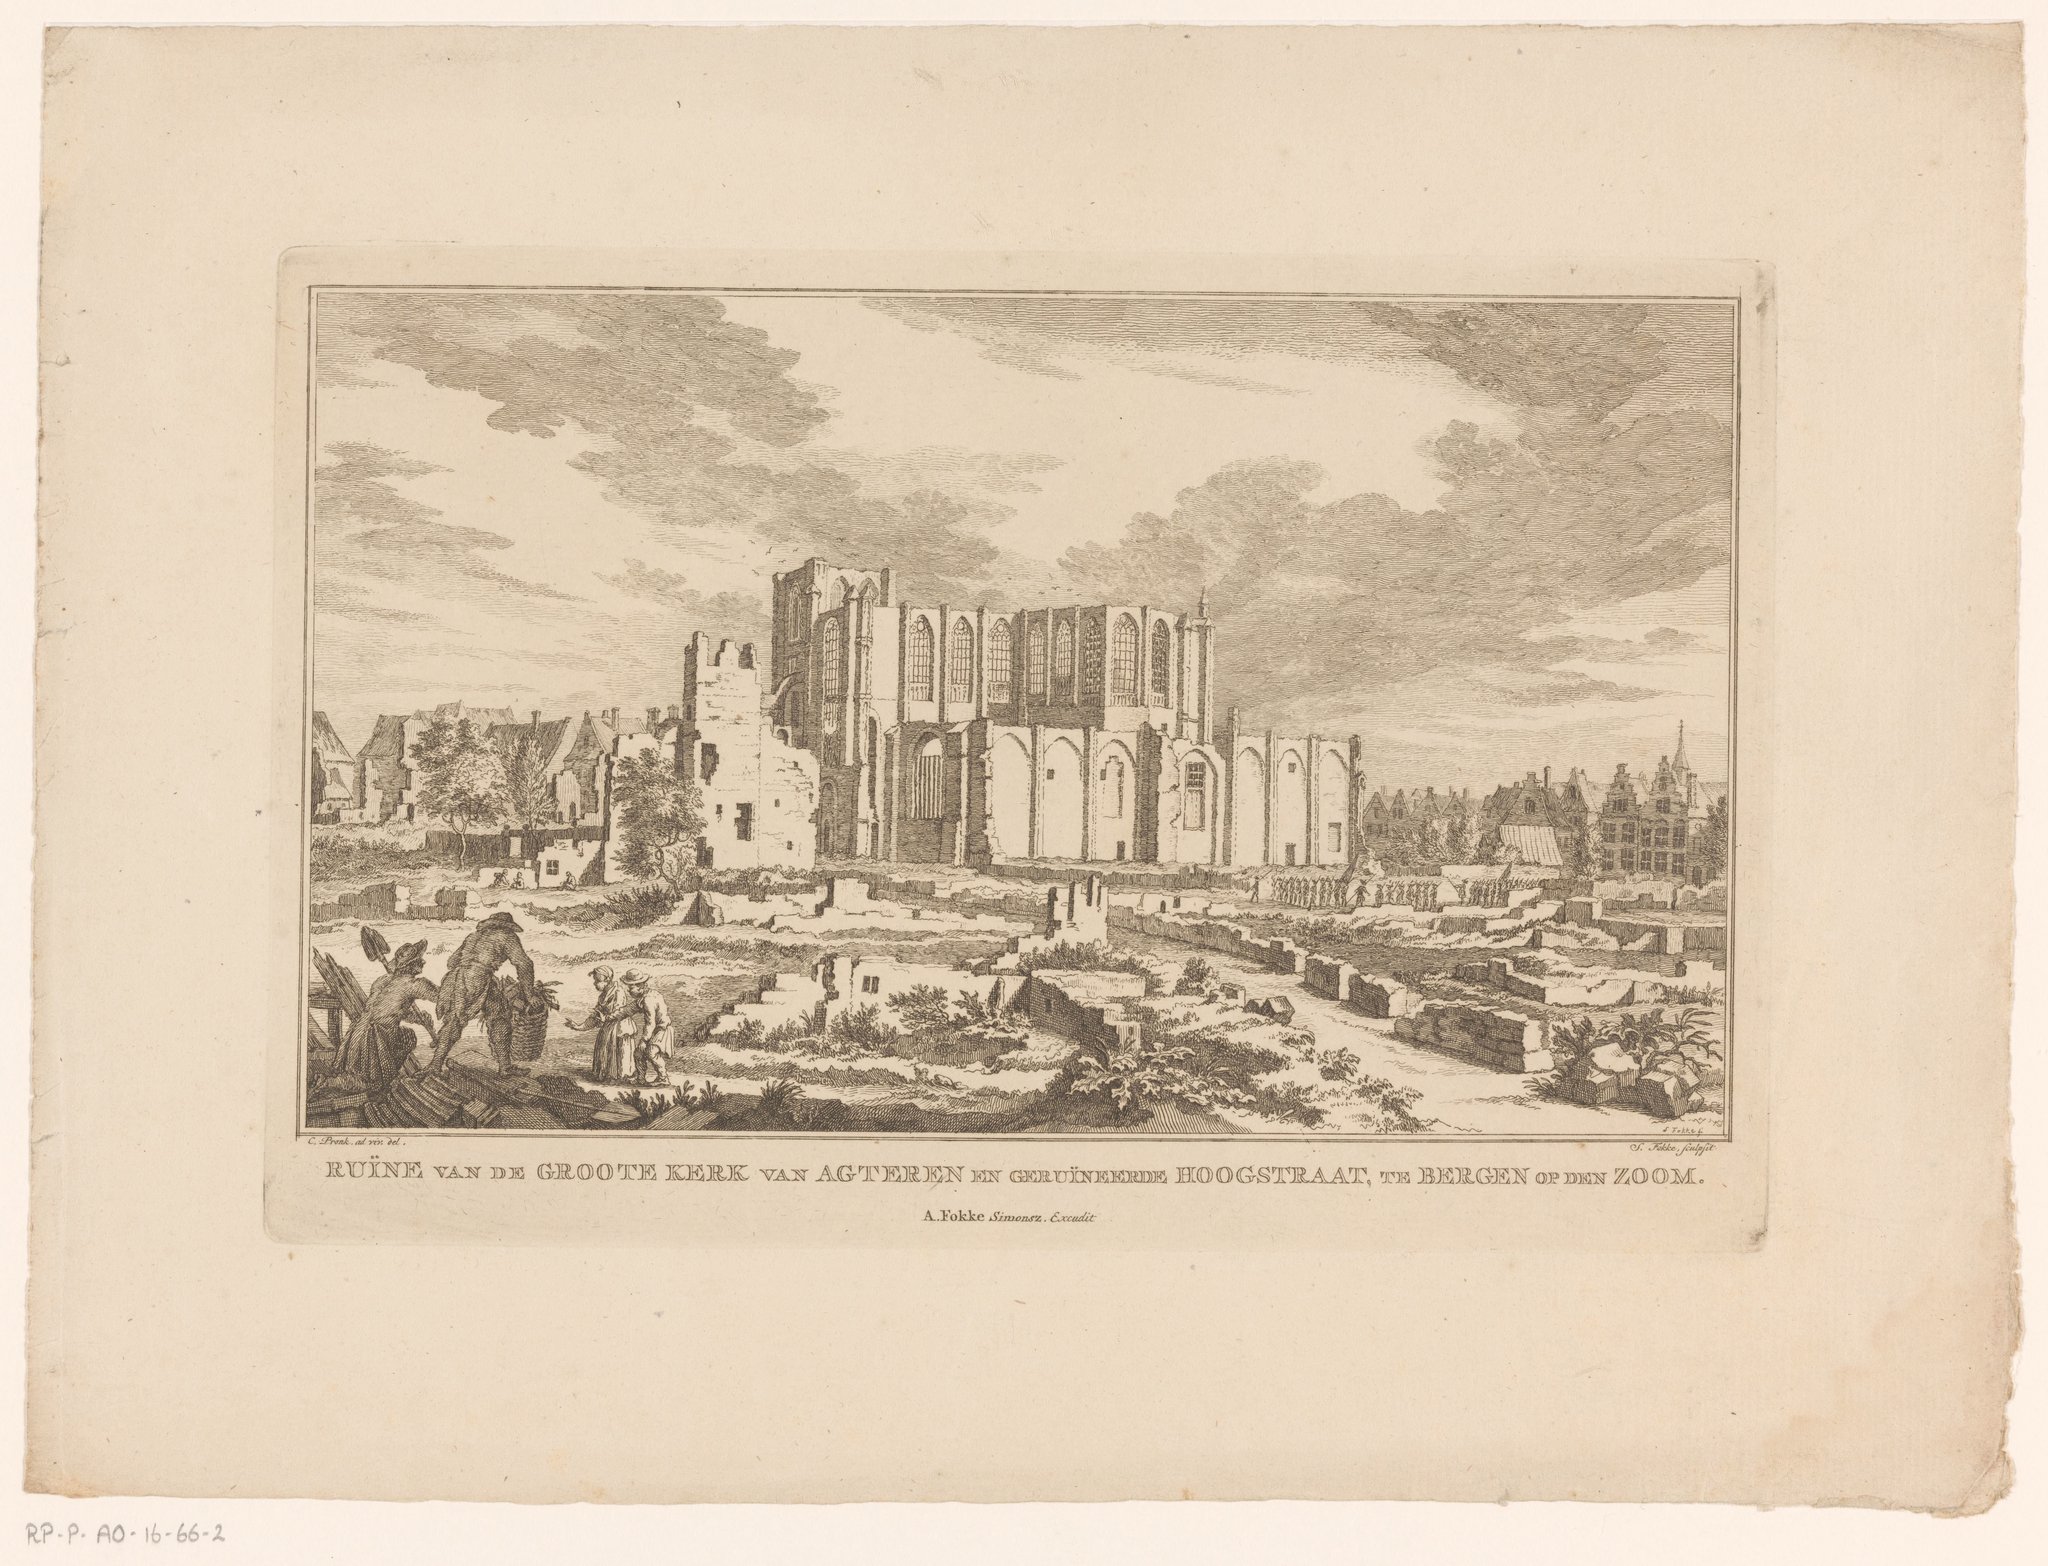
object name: print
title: Tien gezichten van de ruïnes na het beleg en de verwoesting van Bergen op Zoom in 1747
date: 1772-1780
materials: paper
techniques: etching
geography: amsterdam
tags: ruin of church, monastery, etc., devastated, ruined place or city (~ warfare), bergen op zoom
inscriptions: collector's mark: Lugt 2228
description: Prent ook gebruikt in: Beschryving der stad Bergen op den Zoom (…). 1e druk. Amsterdam: Arend Fokke Simonsz., 1780. Muller geeft aan dat de prenten door Simon Fokke in 1772 naar de tekeningen van Pronk uit 1748 zijn vervaardigd. In de Collecties Thuis in Brabant (collecties in Brabantse musea en archieven) is een ontwerptekening (met inv.nr.: BC-Tha oai:tha.uvt.nl:709121) voor deze prent in de serie bewaard met de annotatie: Hoogstraat. na t Leven geschest (sic) door C.Pronk 1748. opgetekent door S. Fokke 1772.